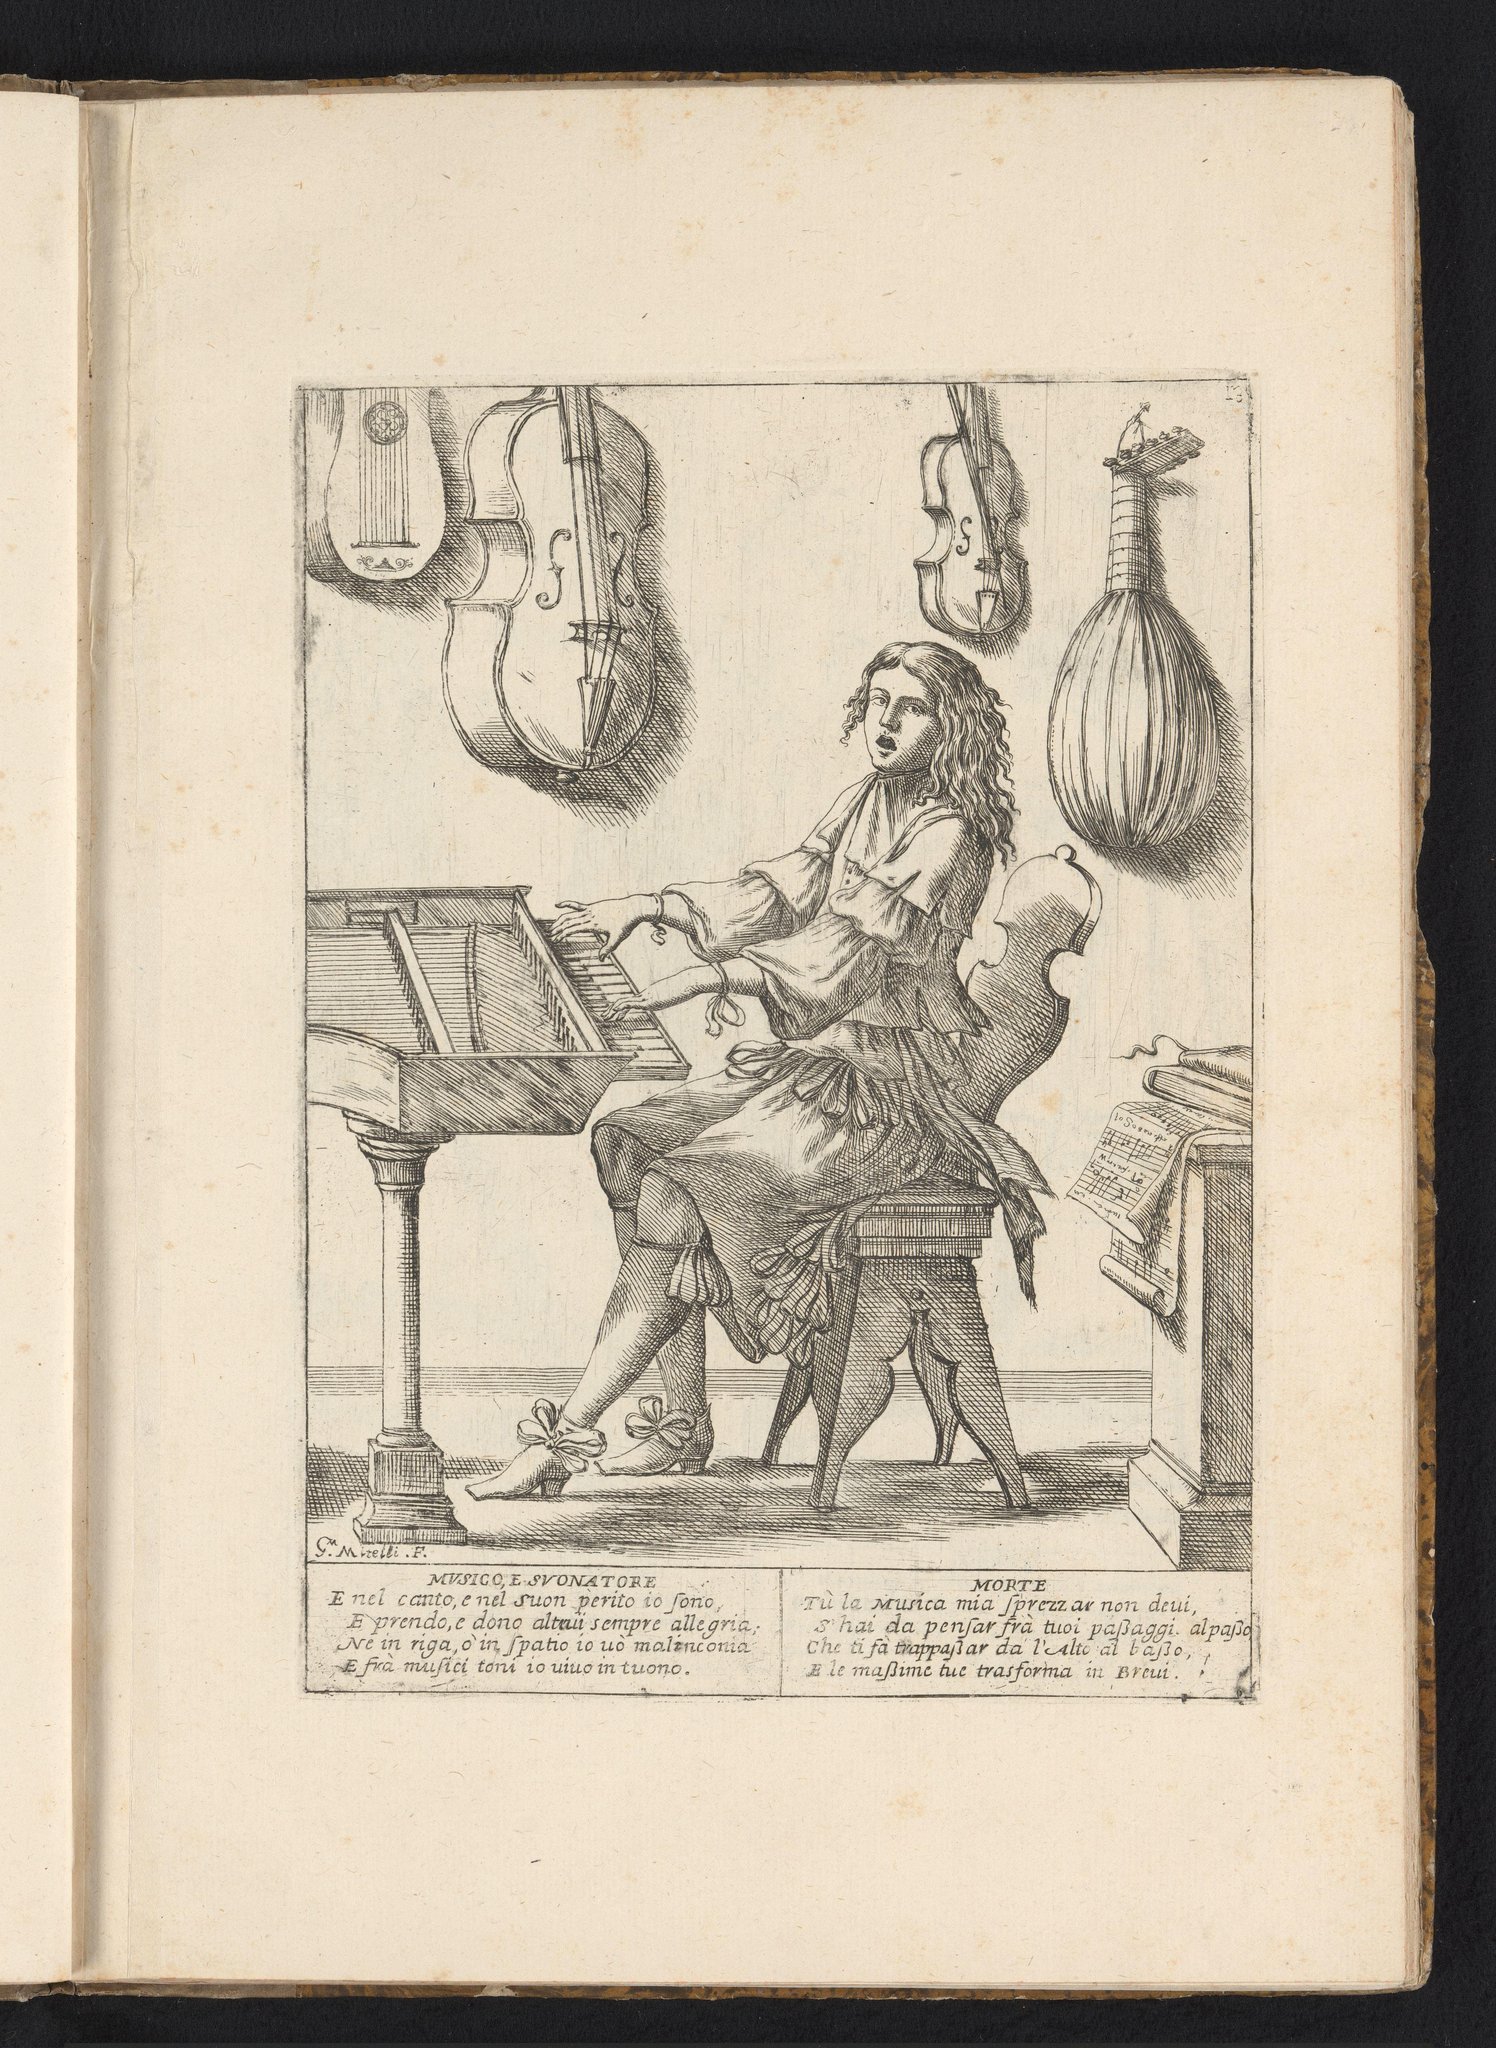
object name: print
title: Le Ventiquattr'Hore dell'humana felicità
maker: giuseppe maria mitelli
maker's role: draughtsman, painter, print maker, publisher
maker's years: 1634-1718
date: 1675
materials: paper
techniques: engraving, etching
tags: one person playing keyboard instrument, scenes symbolizing 'vanitas', the 24 hours of day and night, violin, fiddle, viola, violoncello; double bass, clavichord, harpsichord, singer accompanying himself, cithern, mandolin, guitar, balalaika, personifications ~ the life of man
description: Een jonge muzikant (Musico e Suonatore) speelt en zingt zittend achter een klavecimbel. Aan de wand hangen andere muziekinstrumenten: gitaar, cello, luit en viool. Met twee vierregelige verzen in het Italiaans. Genummerd rechtsboven: 13. Onderdeel van de serie 'De vierentwintig uren van het menselijk geluk'.